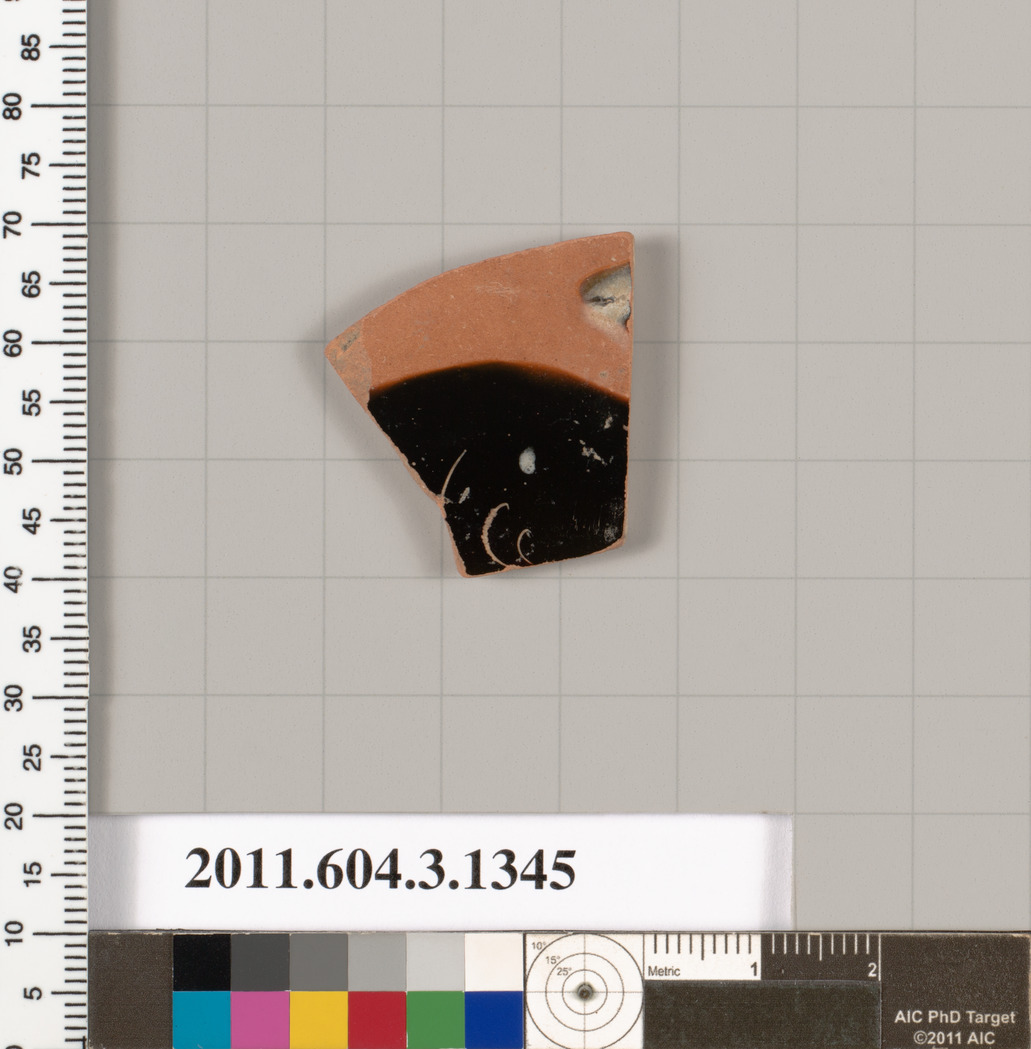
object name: skyphos fragment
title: Terracotta fragment of a skyphos (deep drinking cup)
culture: greek, attic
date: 500-468 BCE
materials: terracotta